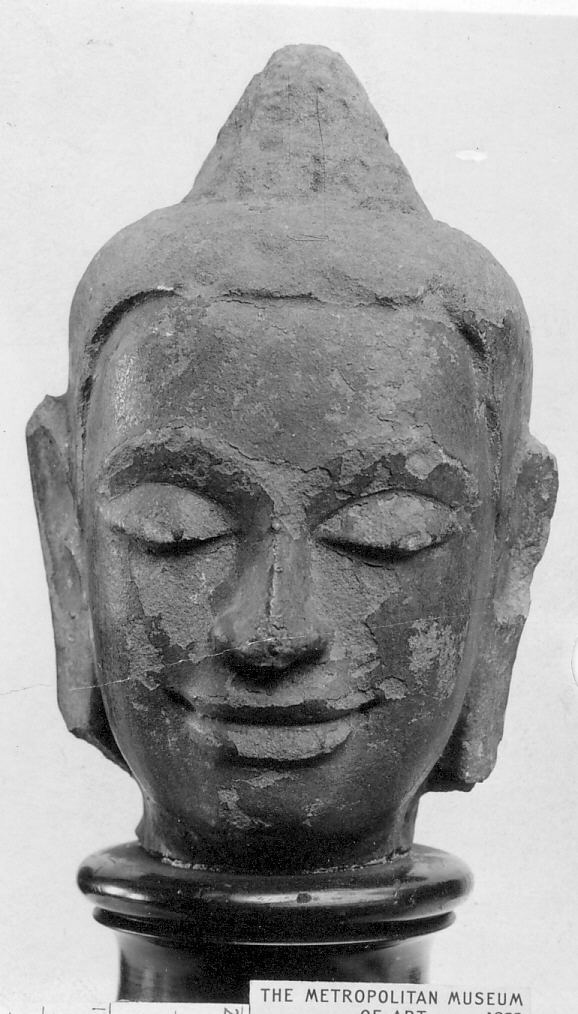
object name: head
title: Head of a Buddha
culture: cambodian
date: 801-900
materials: lacquer, stone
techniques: gilding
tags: heads,buddhism,buddha